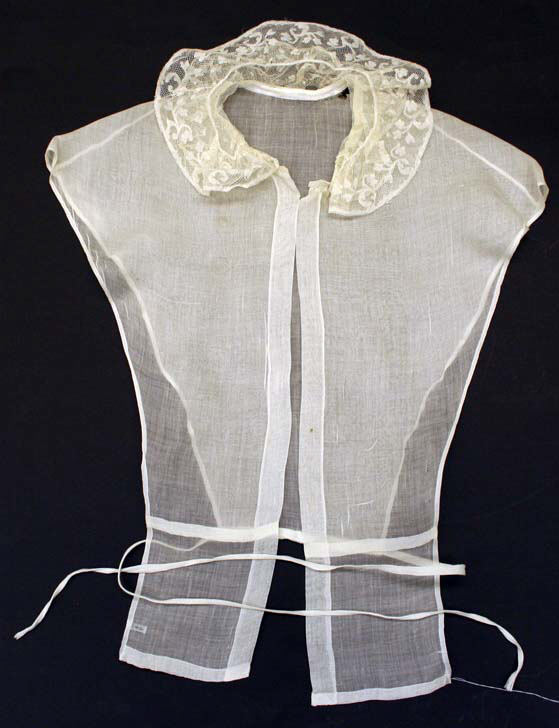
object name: dickey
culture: american or european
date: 1801-1833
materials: cotton